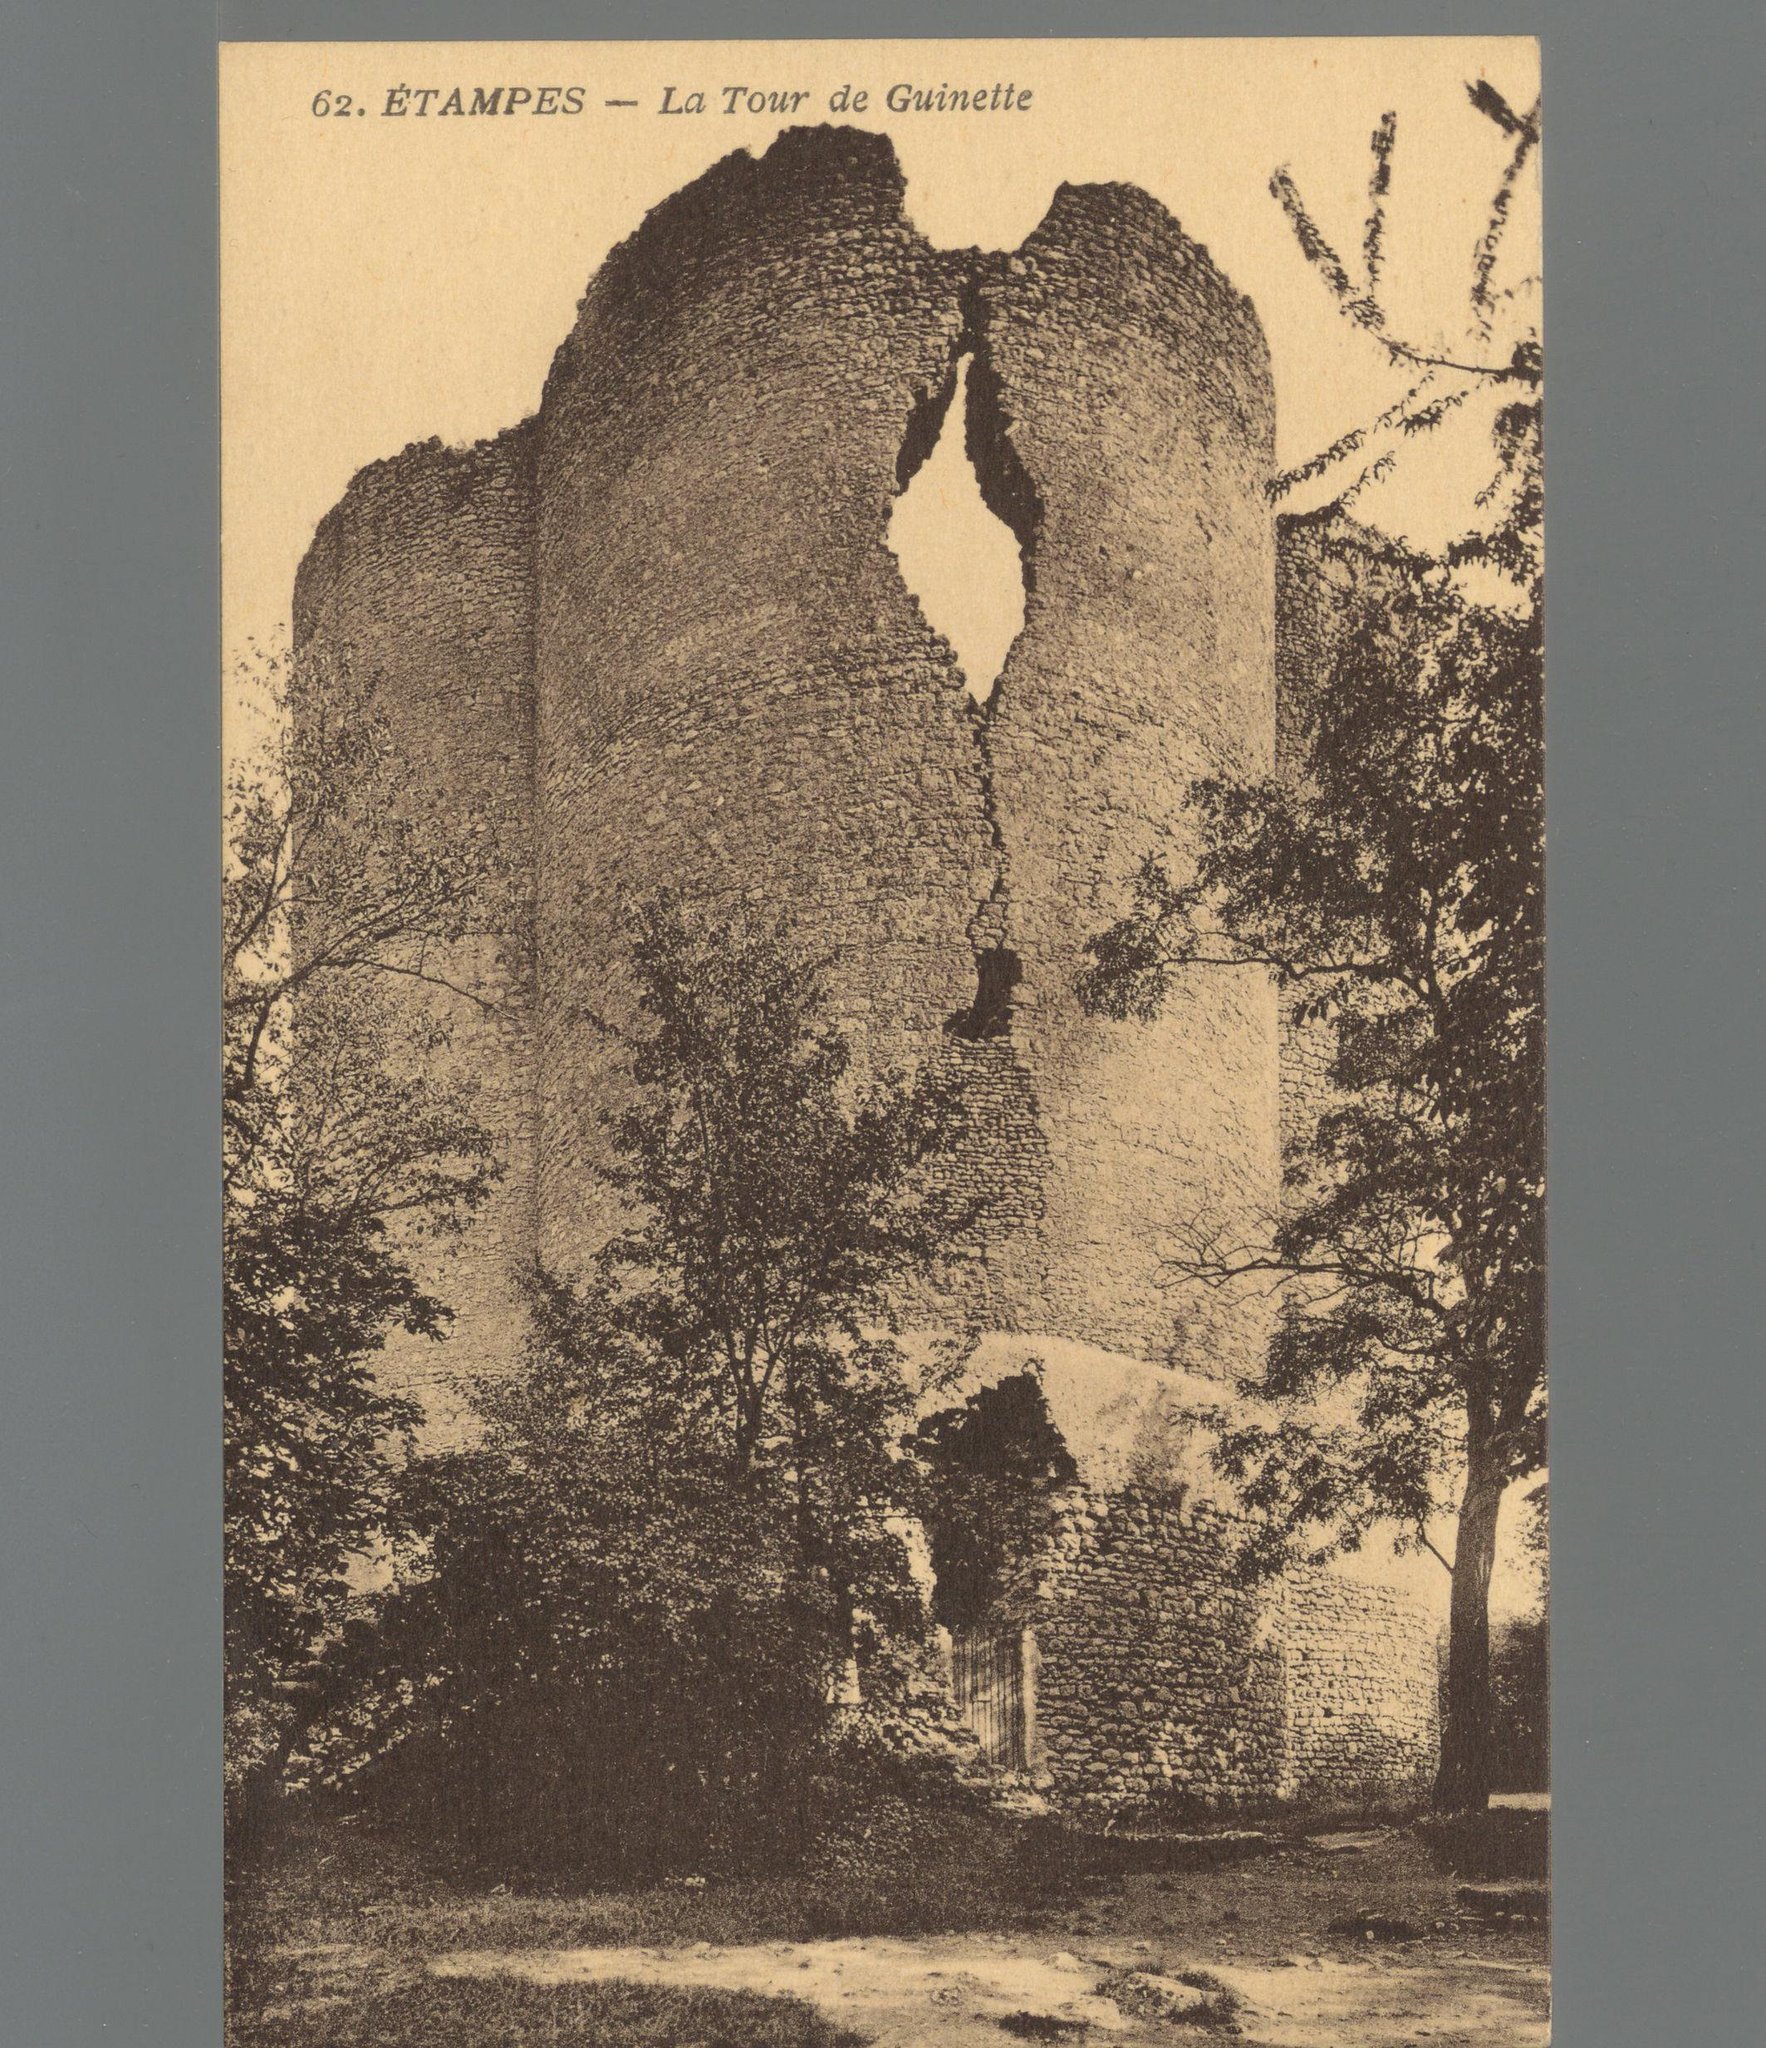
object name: ansichtkaart, prentbriefkaart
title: Étampes - La Tour de Guinette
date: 1903-1930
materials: cardboard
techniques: photograph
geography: etampes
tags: towers ~ fortified city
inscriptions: collector's mark: ‘AFE v S’